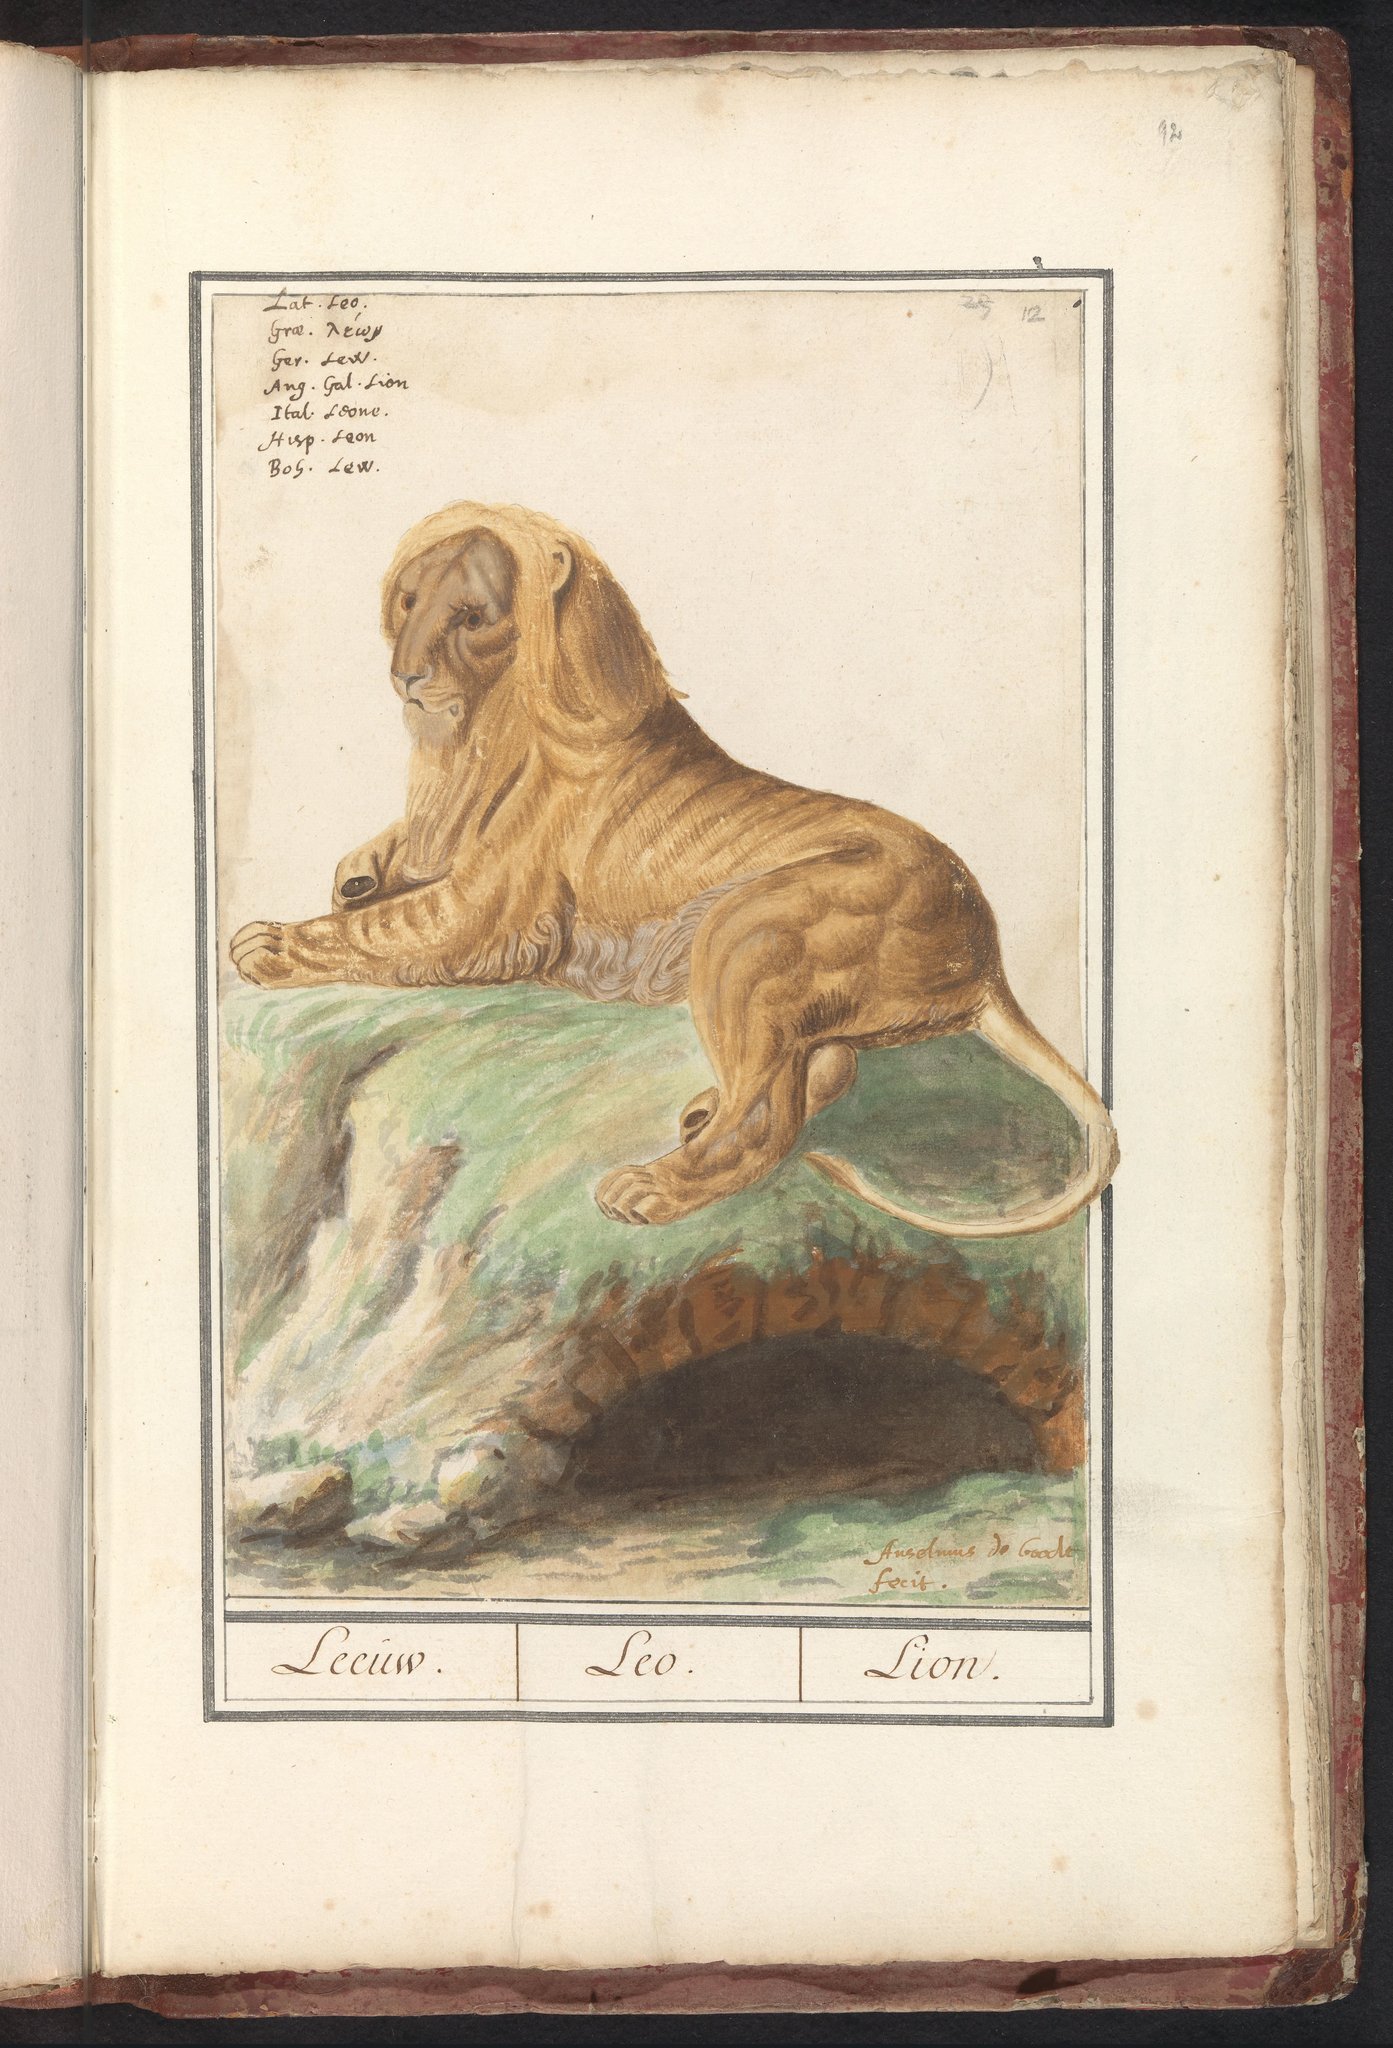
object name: drawing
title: Leeuw. / Leo. / Lion.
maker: anselmus boëtius de boodt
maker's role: draughtsman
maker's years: 1550-1632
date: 1596-1610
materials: paint, ink, paper, watercolor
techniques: brush, pen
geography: prague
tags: beasts of prey, predatory animals: lion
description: Leeuw. Genummerd rechtsboven: 12. Linksboven de naam in zeven talen. Onderdeel van het eerste album met tekeningen van viervoeters. Eerste van twaalf albums met tekeningen van dieren, vogels en planten bekend rond 1600, gemaakt in opdracht van keizer Rudolf II. Met toelichting in Nederlands, Latijn en Frans.